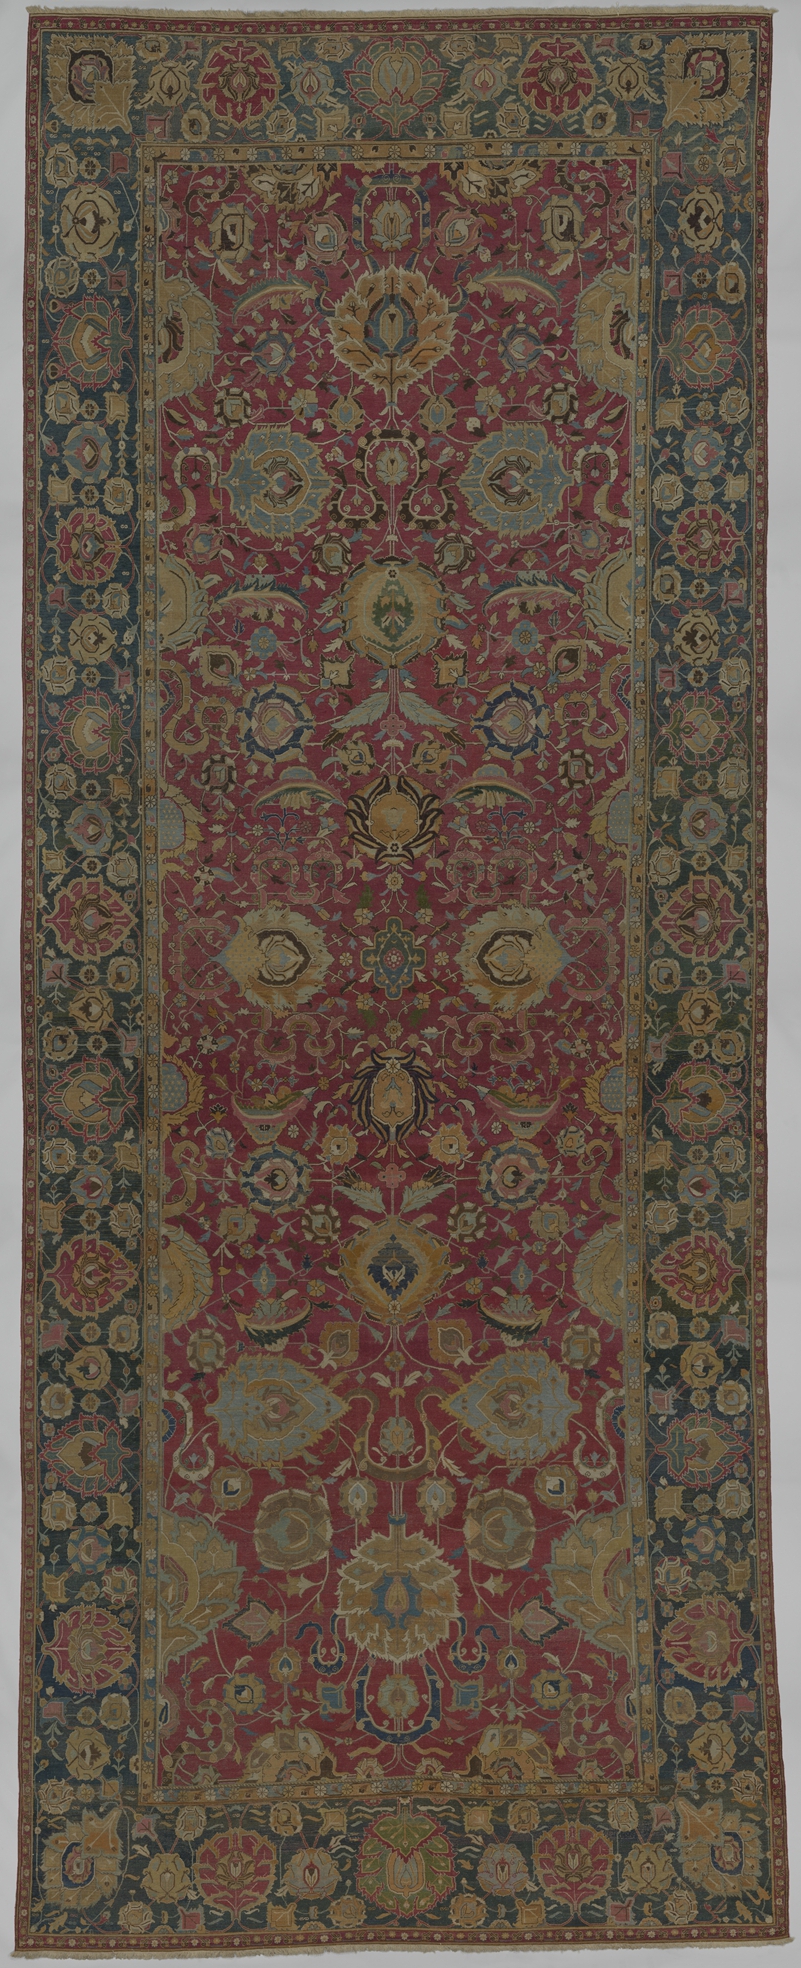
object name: carpet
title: Indo-Persian carpet with vine scroll and palmette pattern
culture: indo-persian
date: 1634-1666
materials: cotton, wool